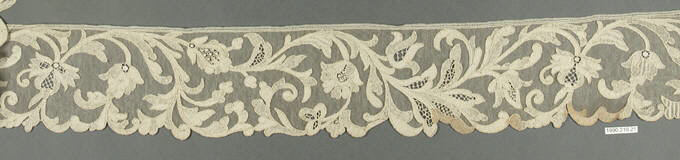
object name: edging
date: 1867-1900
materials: cotton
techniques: lace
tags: flowers